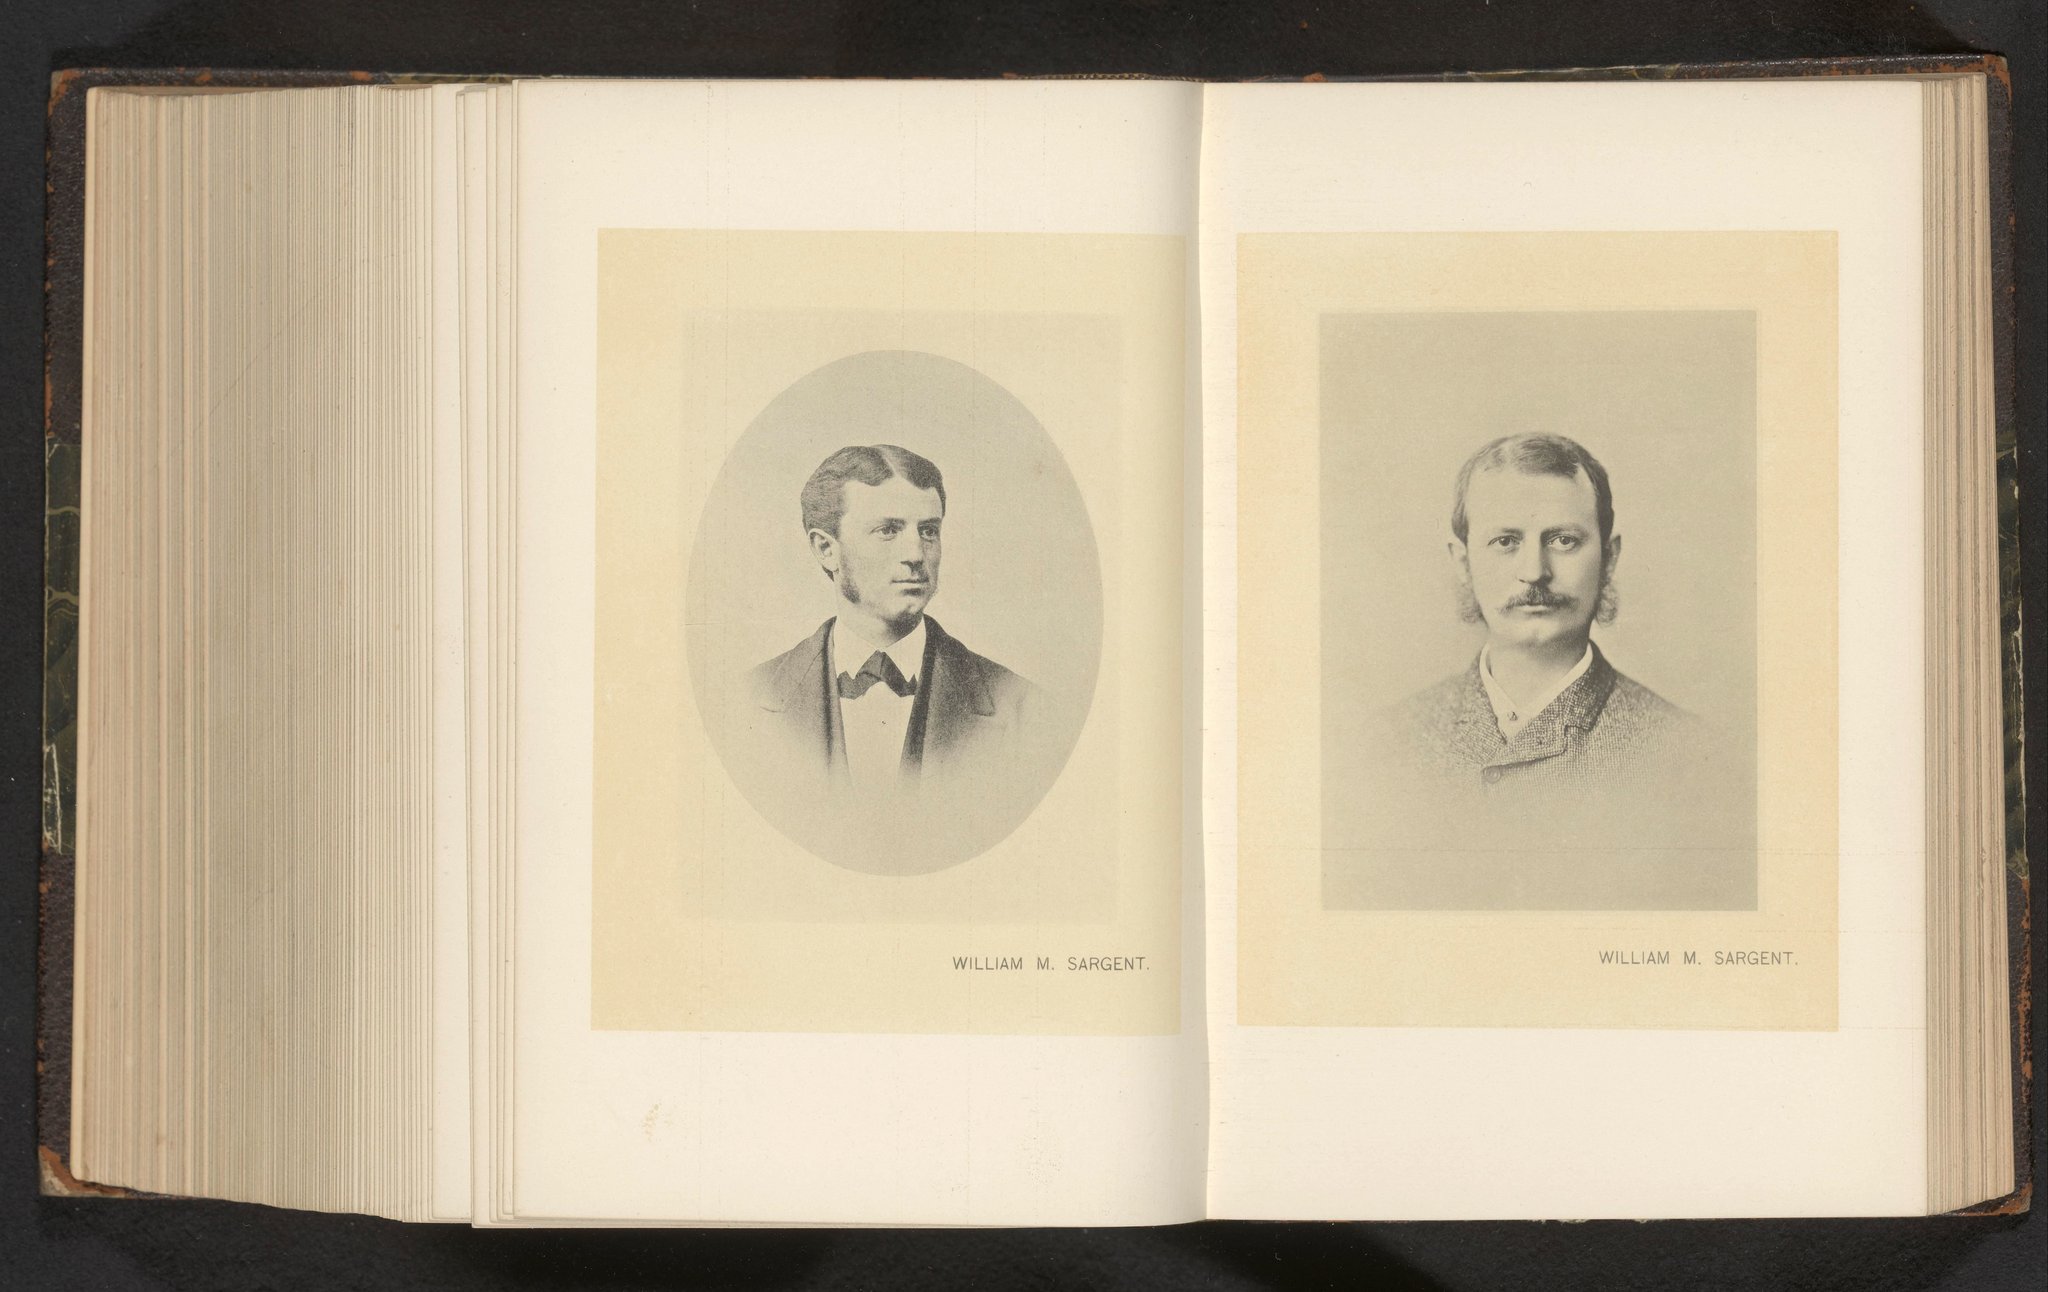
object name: photomechanical print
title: William M. Sargent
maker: Anonymous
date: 1869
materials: paper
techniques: photoaquatint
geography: boston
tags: adult man